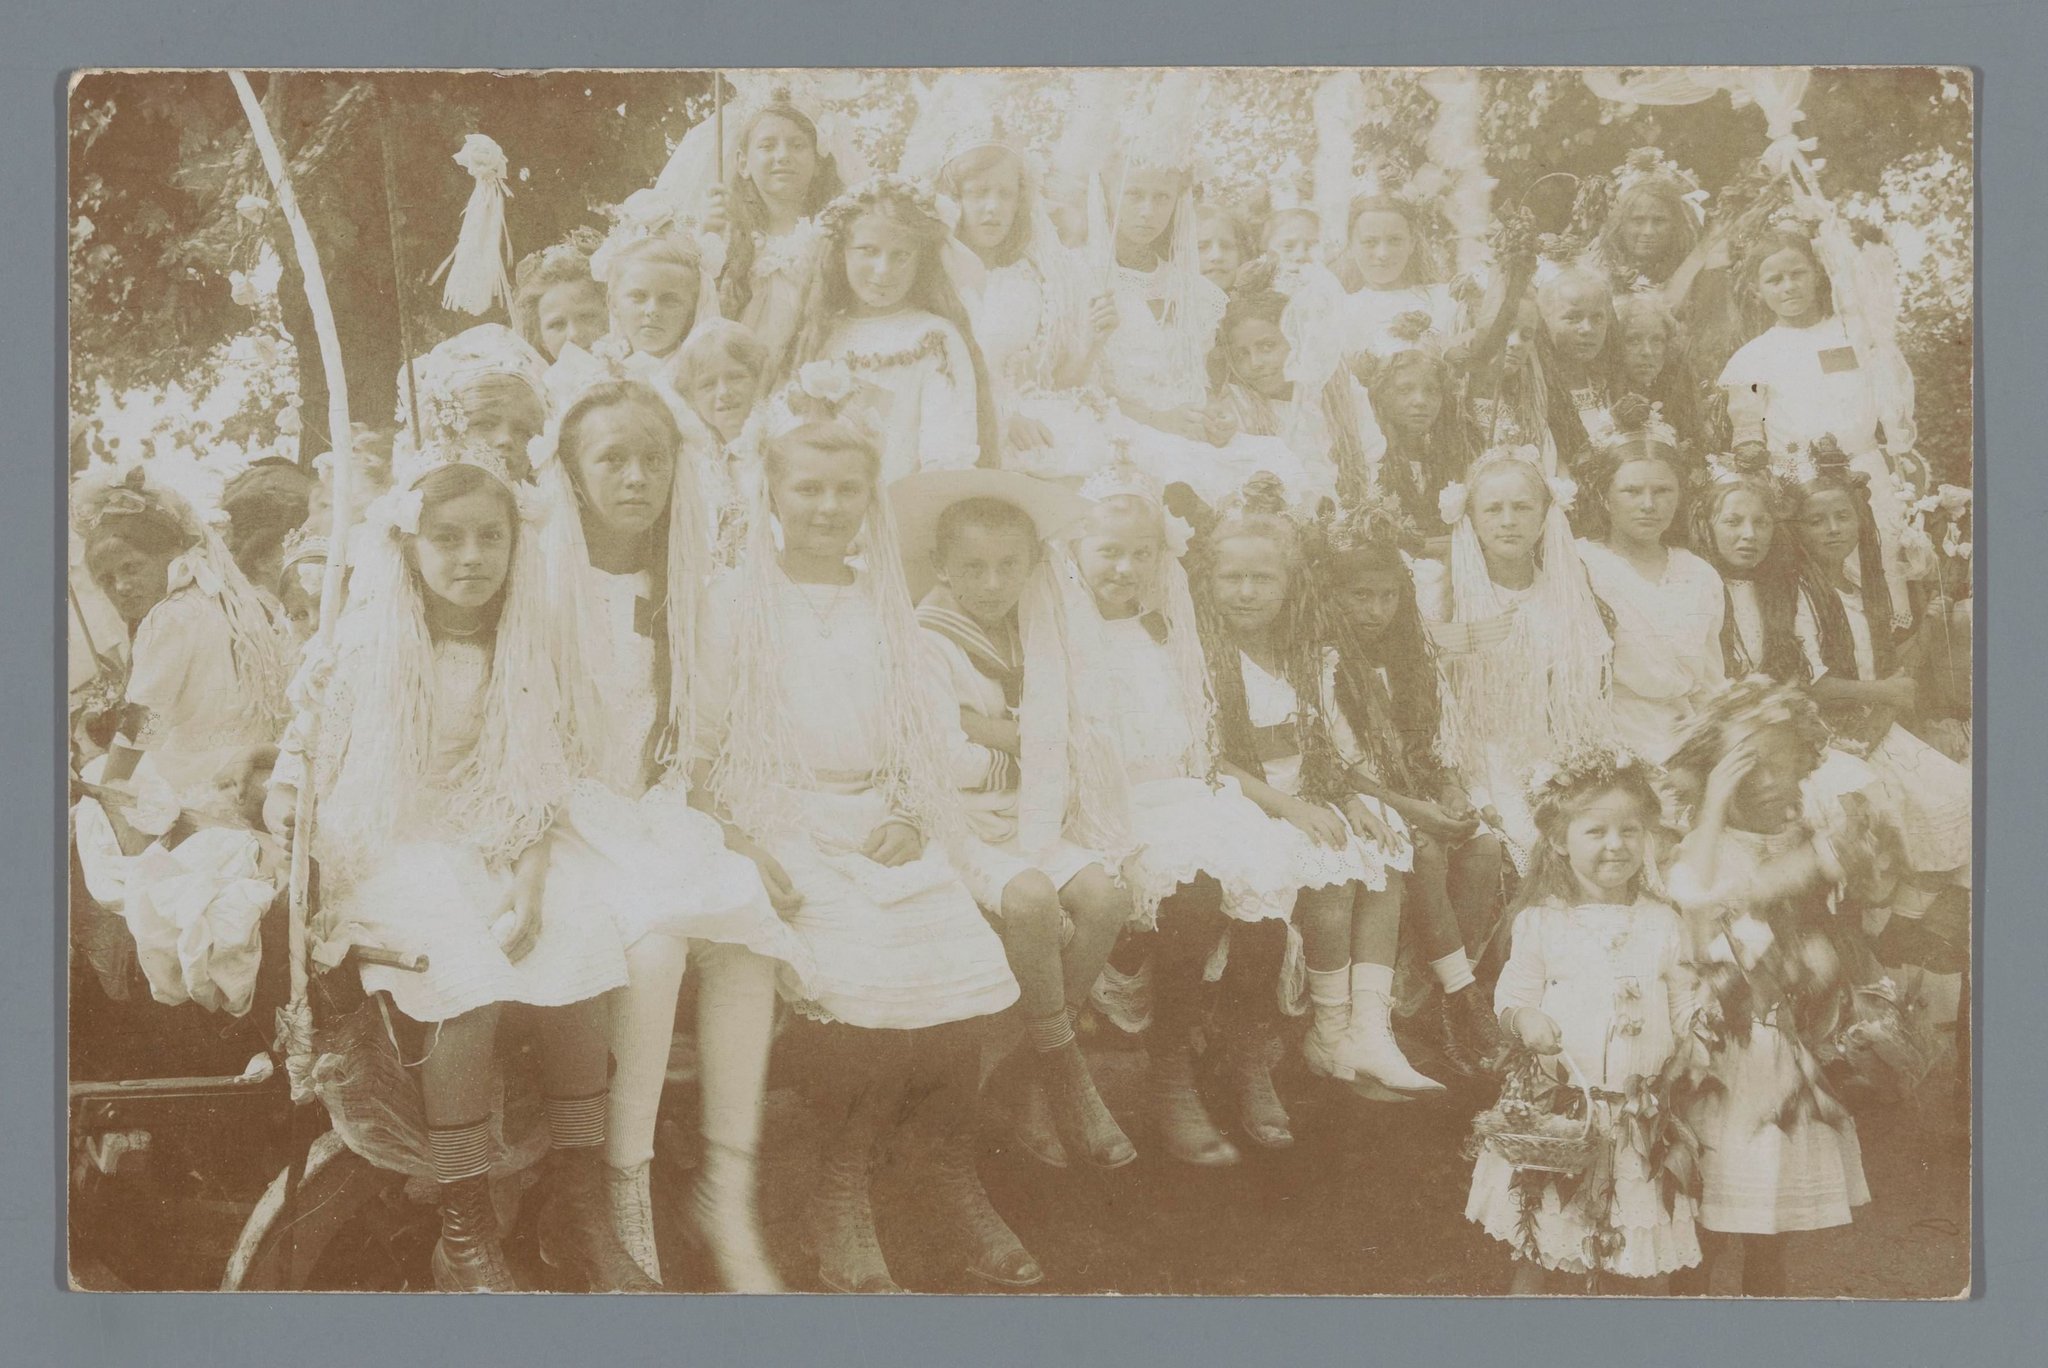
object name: ansichtkaart, prentbriefkaart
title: Groepsportret van verklede meisjes (vermoedelijk) voor een optocht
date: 1910-1920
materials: photographic support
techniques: gelatin silver print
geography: międzyzdroje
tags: periodic celebrations, popular feasts, anonymous historical persons portrayed in a group, in a group-portrait